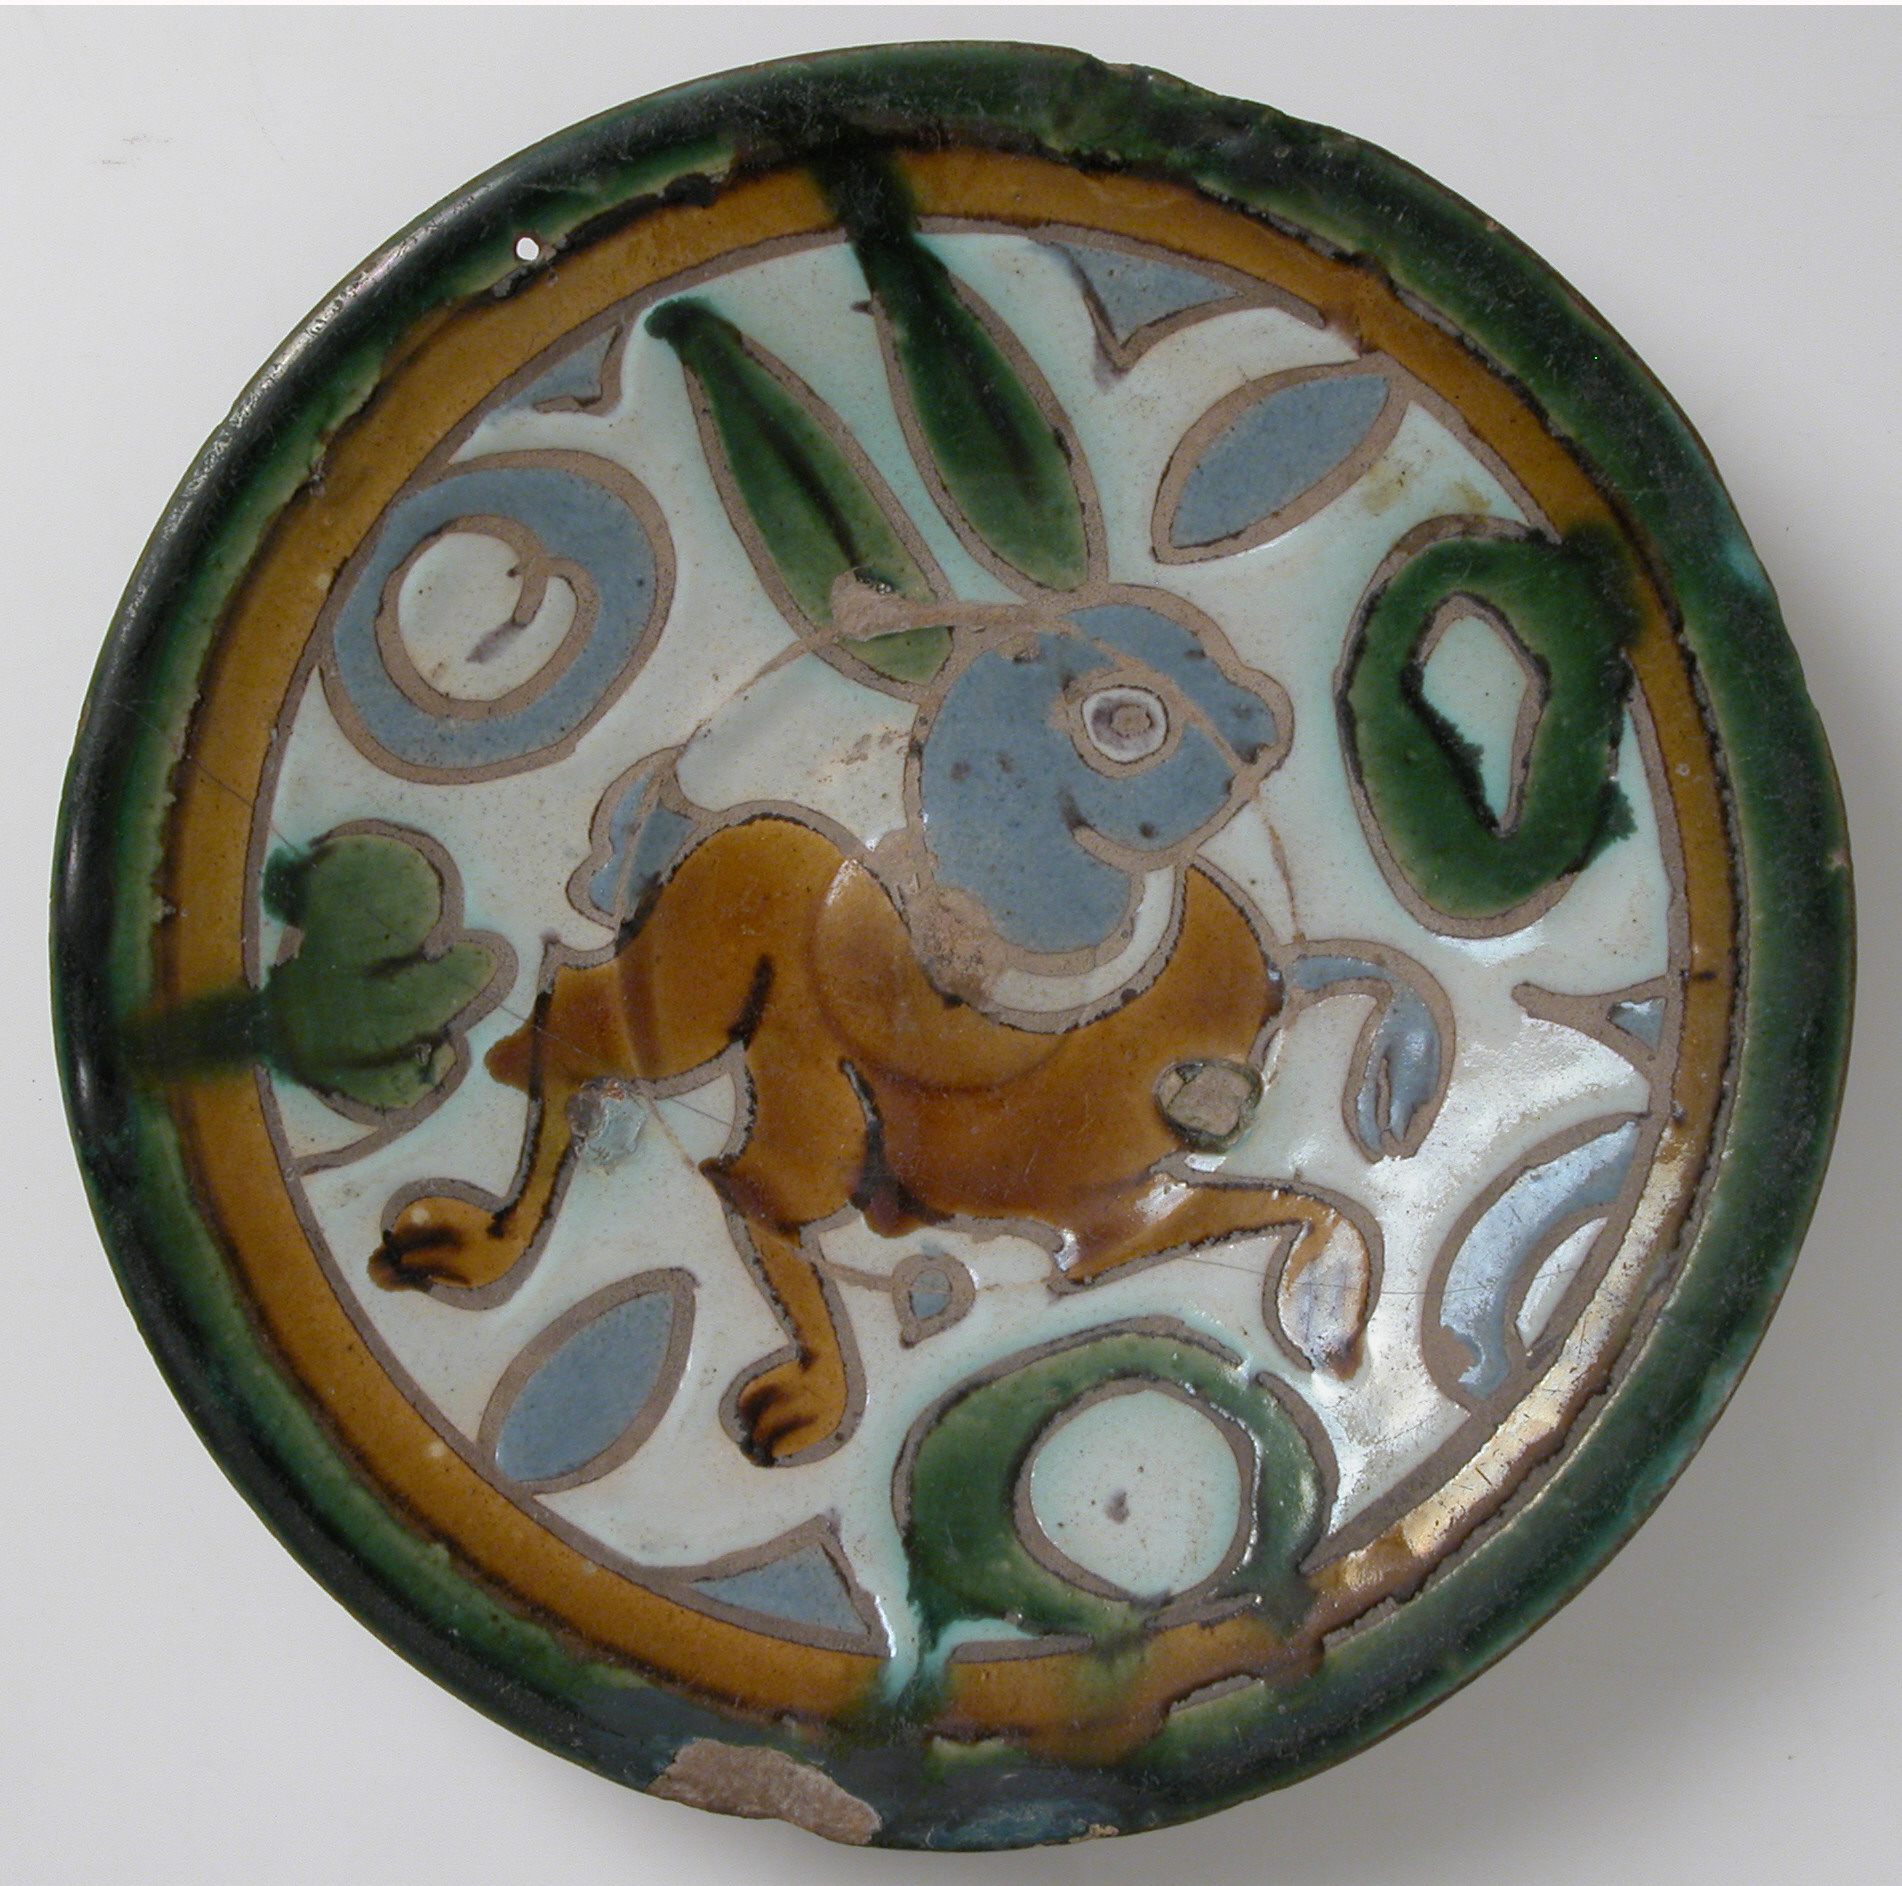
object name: plate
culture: spanish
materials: earthenware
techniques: glazing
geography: spain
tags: animals